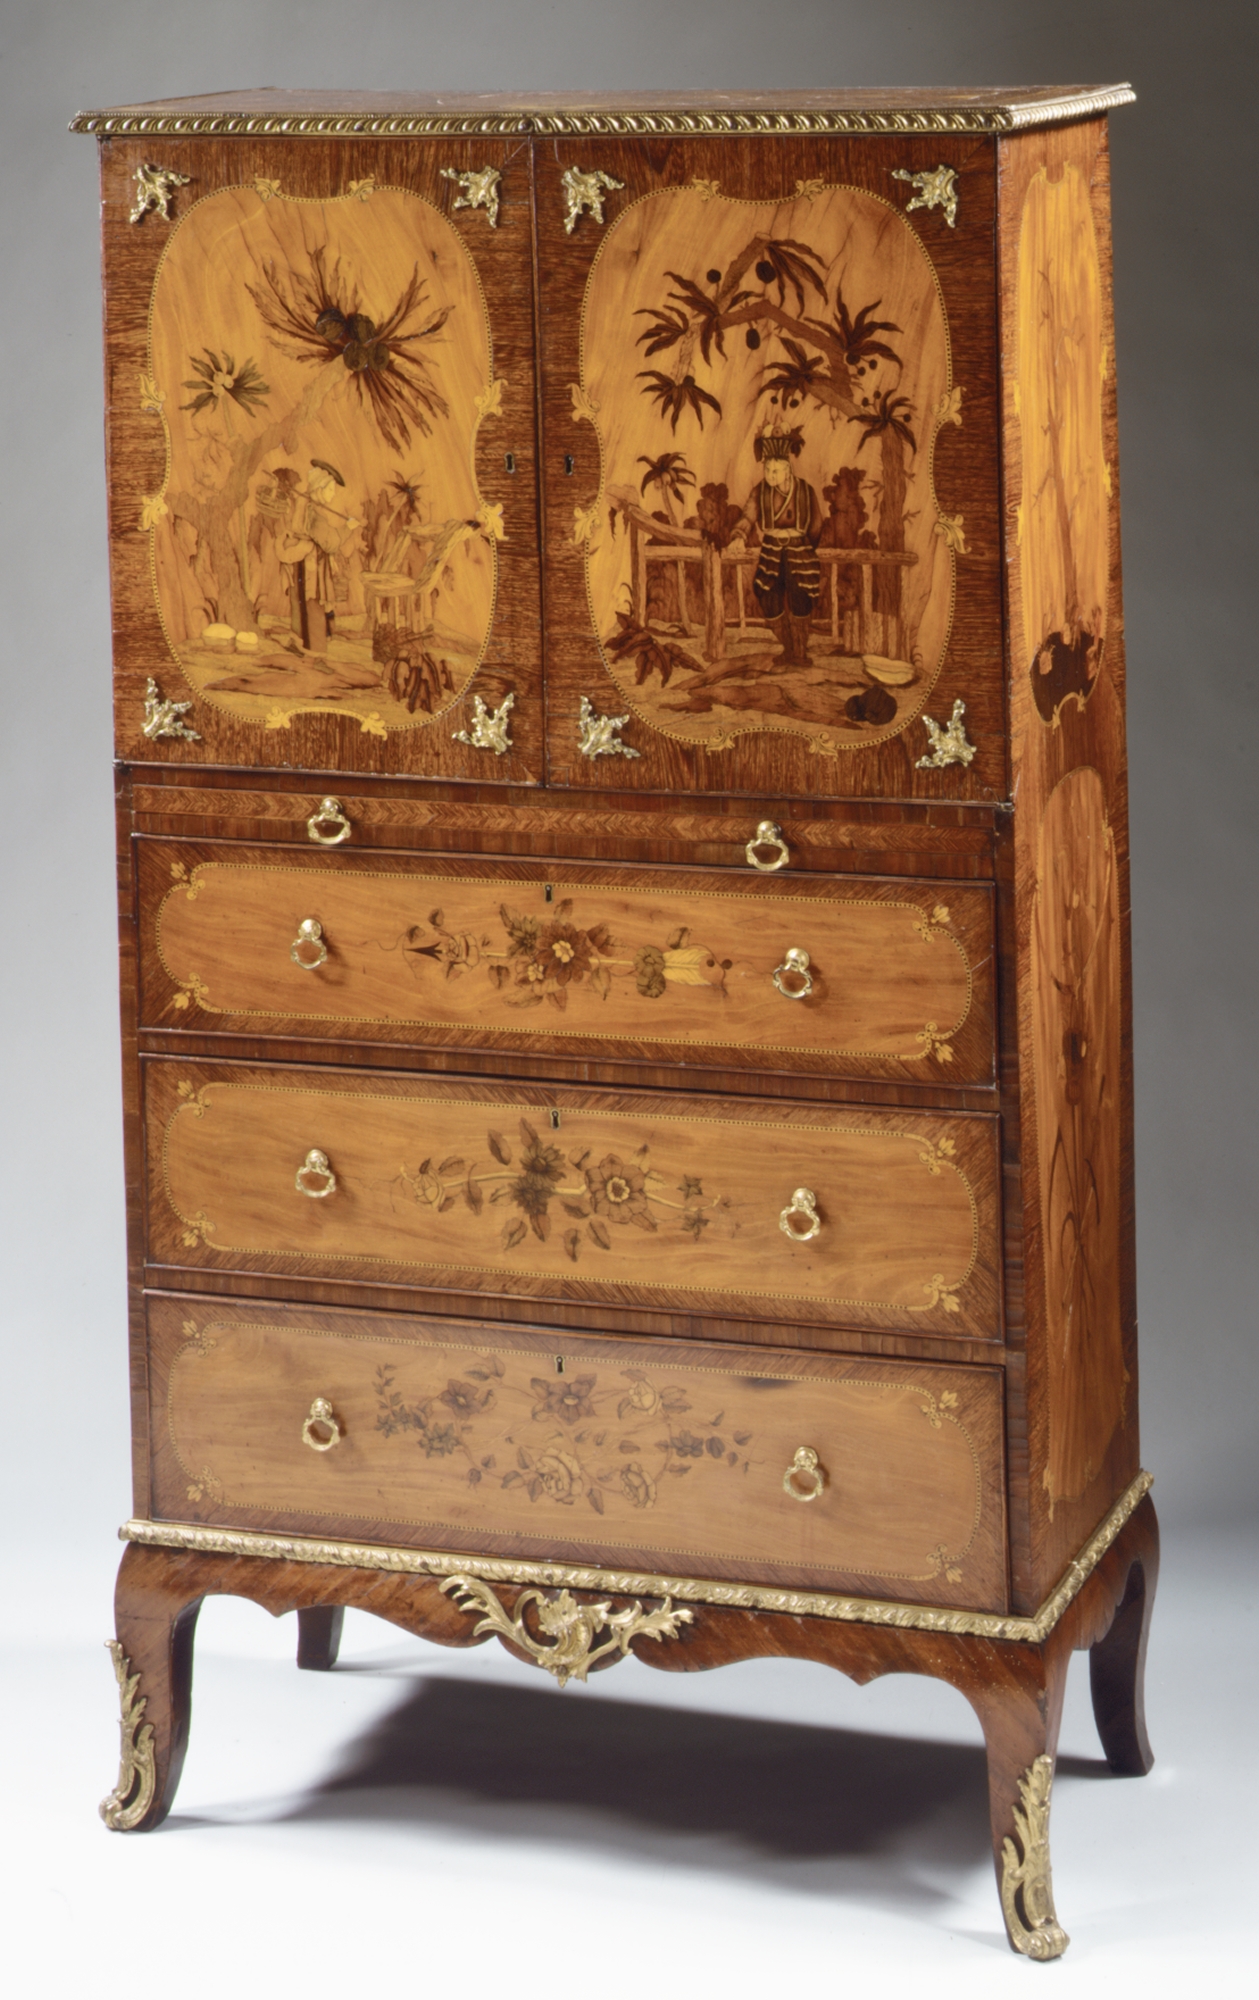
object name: writing cabinet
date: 1770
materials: wood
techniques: tinting, veneering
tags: men